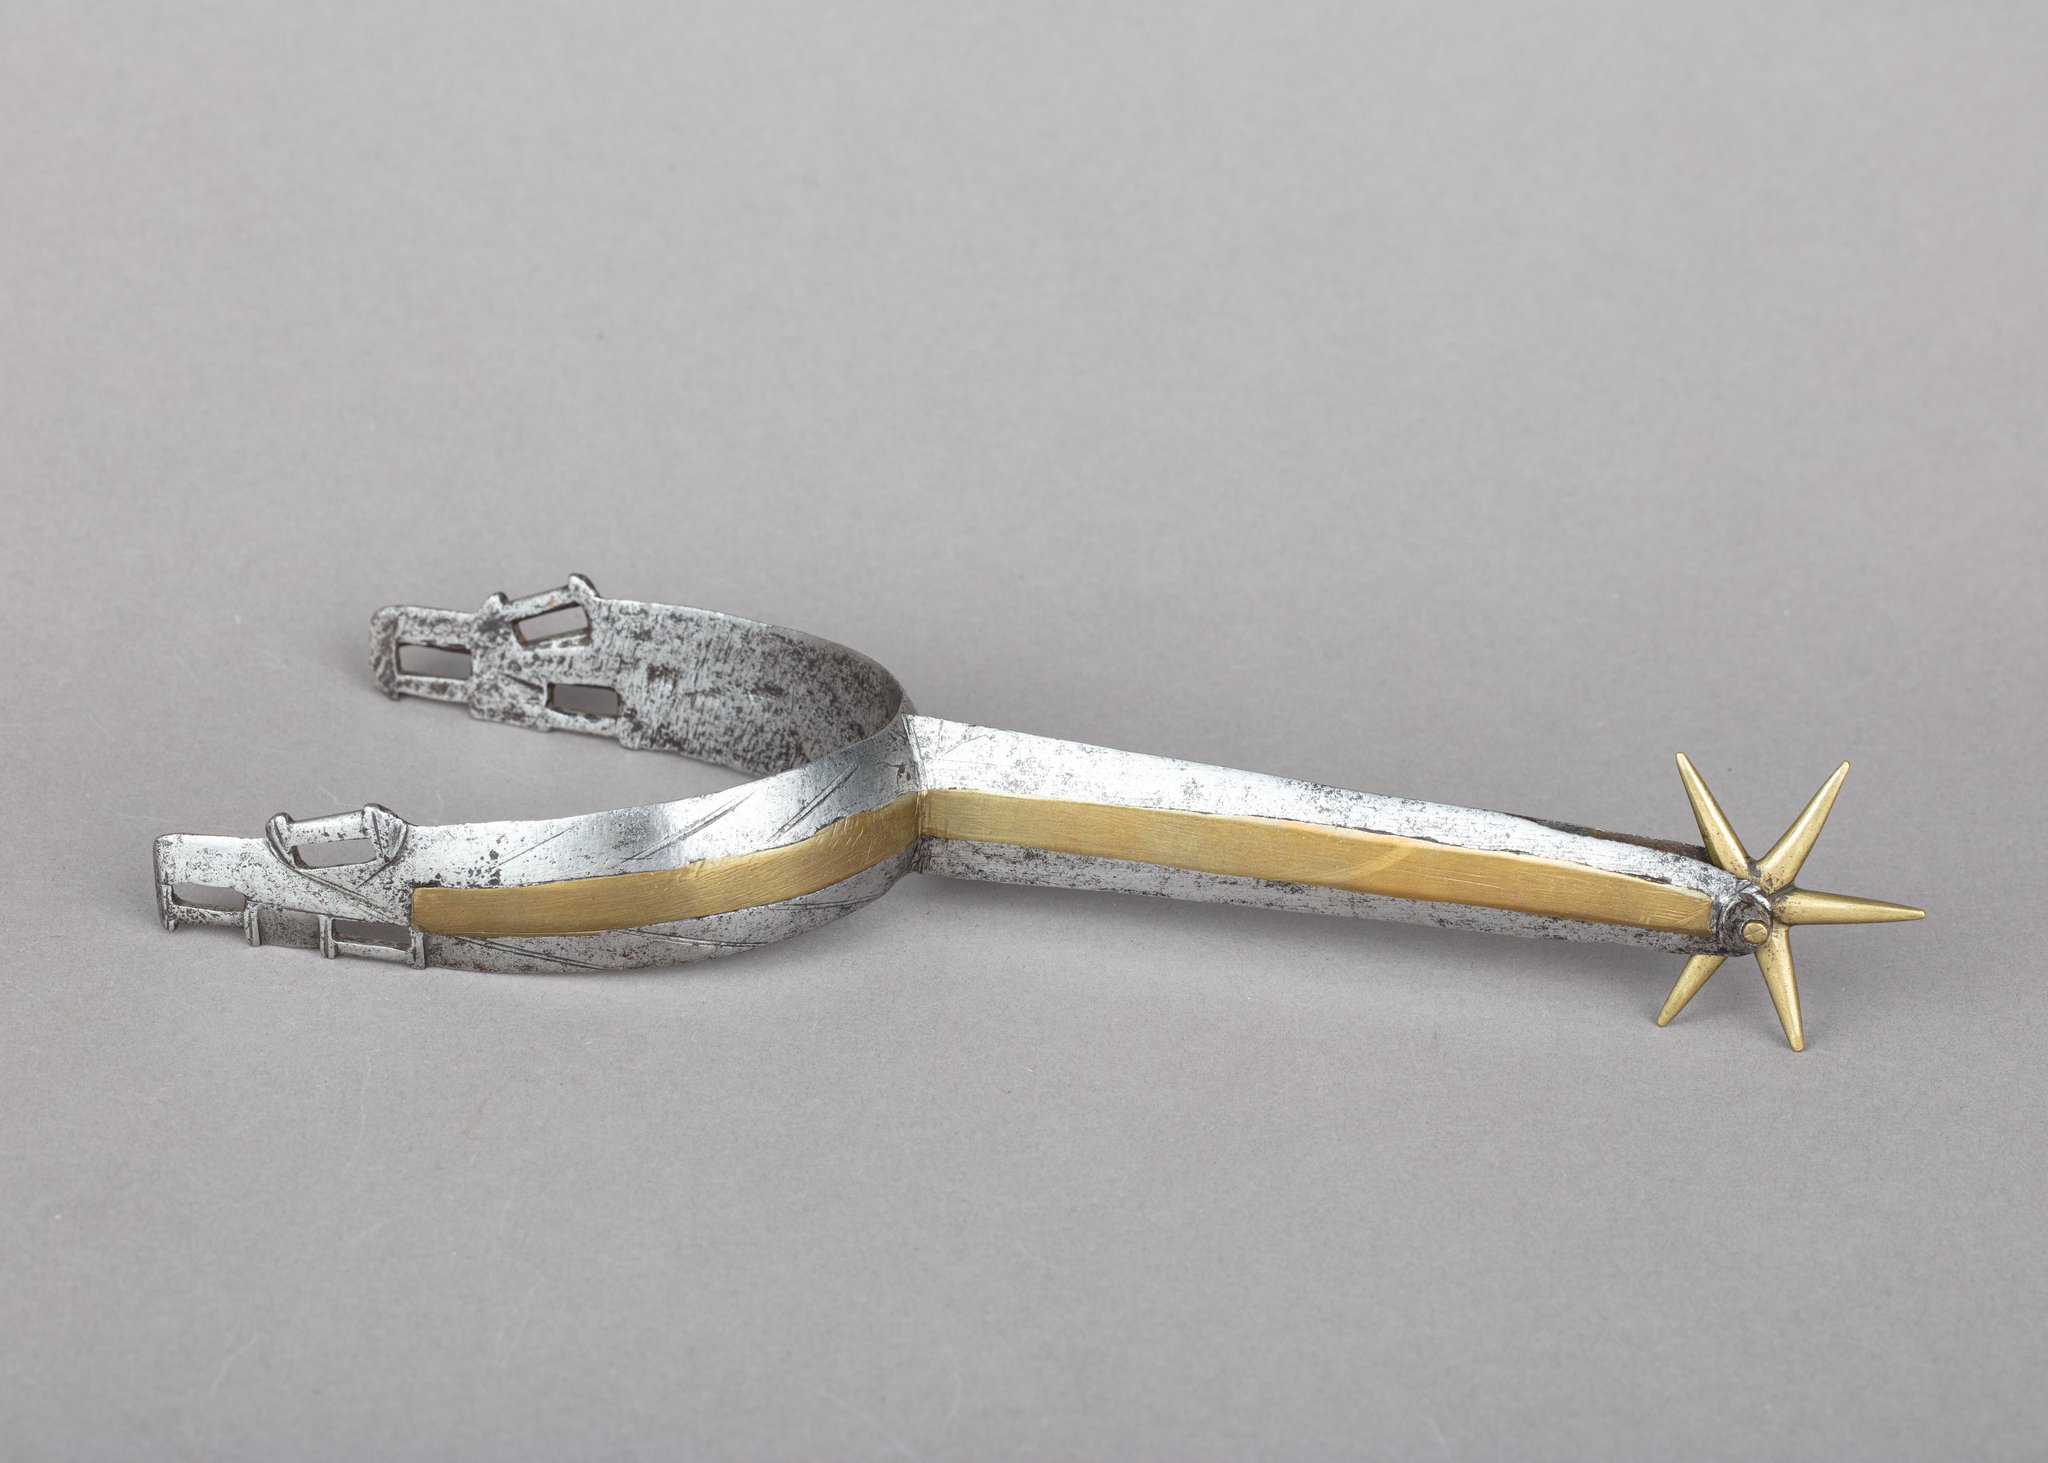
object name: spur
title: Rowel Spur (Left)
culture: german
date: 1501-1533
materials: copper alloy, iron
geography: germany